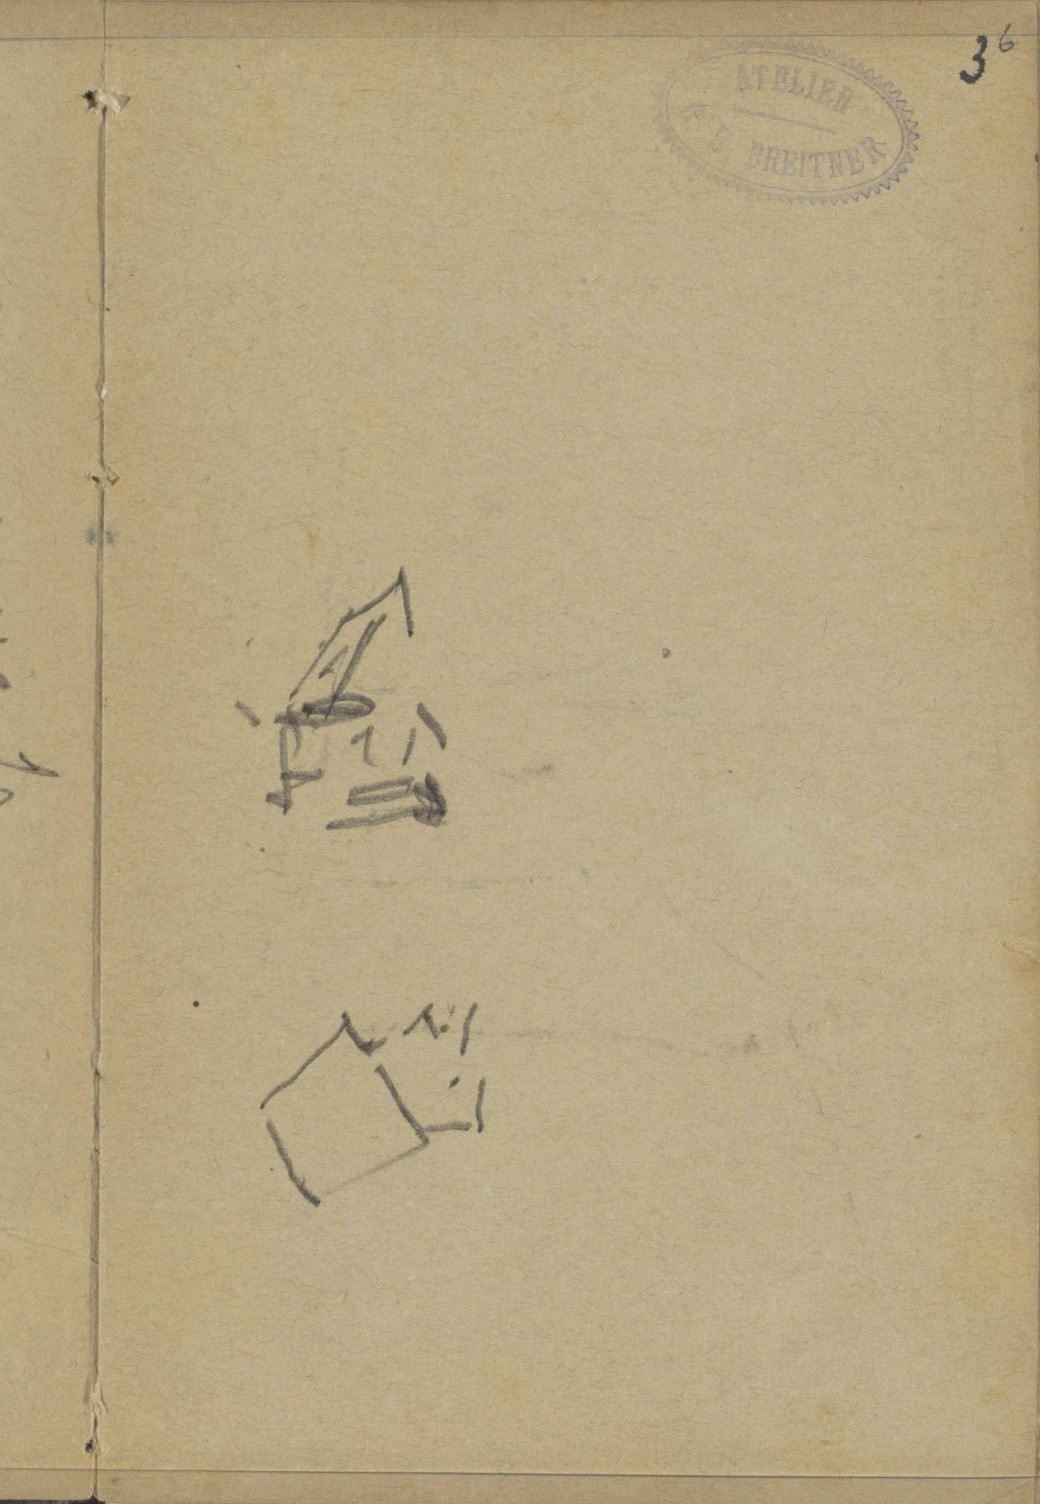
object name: sketchbook leaf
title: Mannenhoofd met helm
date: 1887-1891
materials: paper, pencil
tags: helmet, head (human)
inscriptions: workshop stamp: Lugt 291d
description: Pagina 6 uit een schetsboek met 83 bladen.